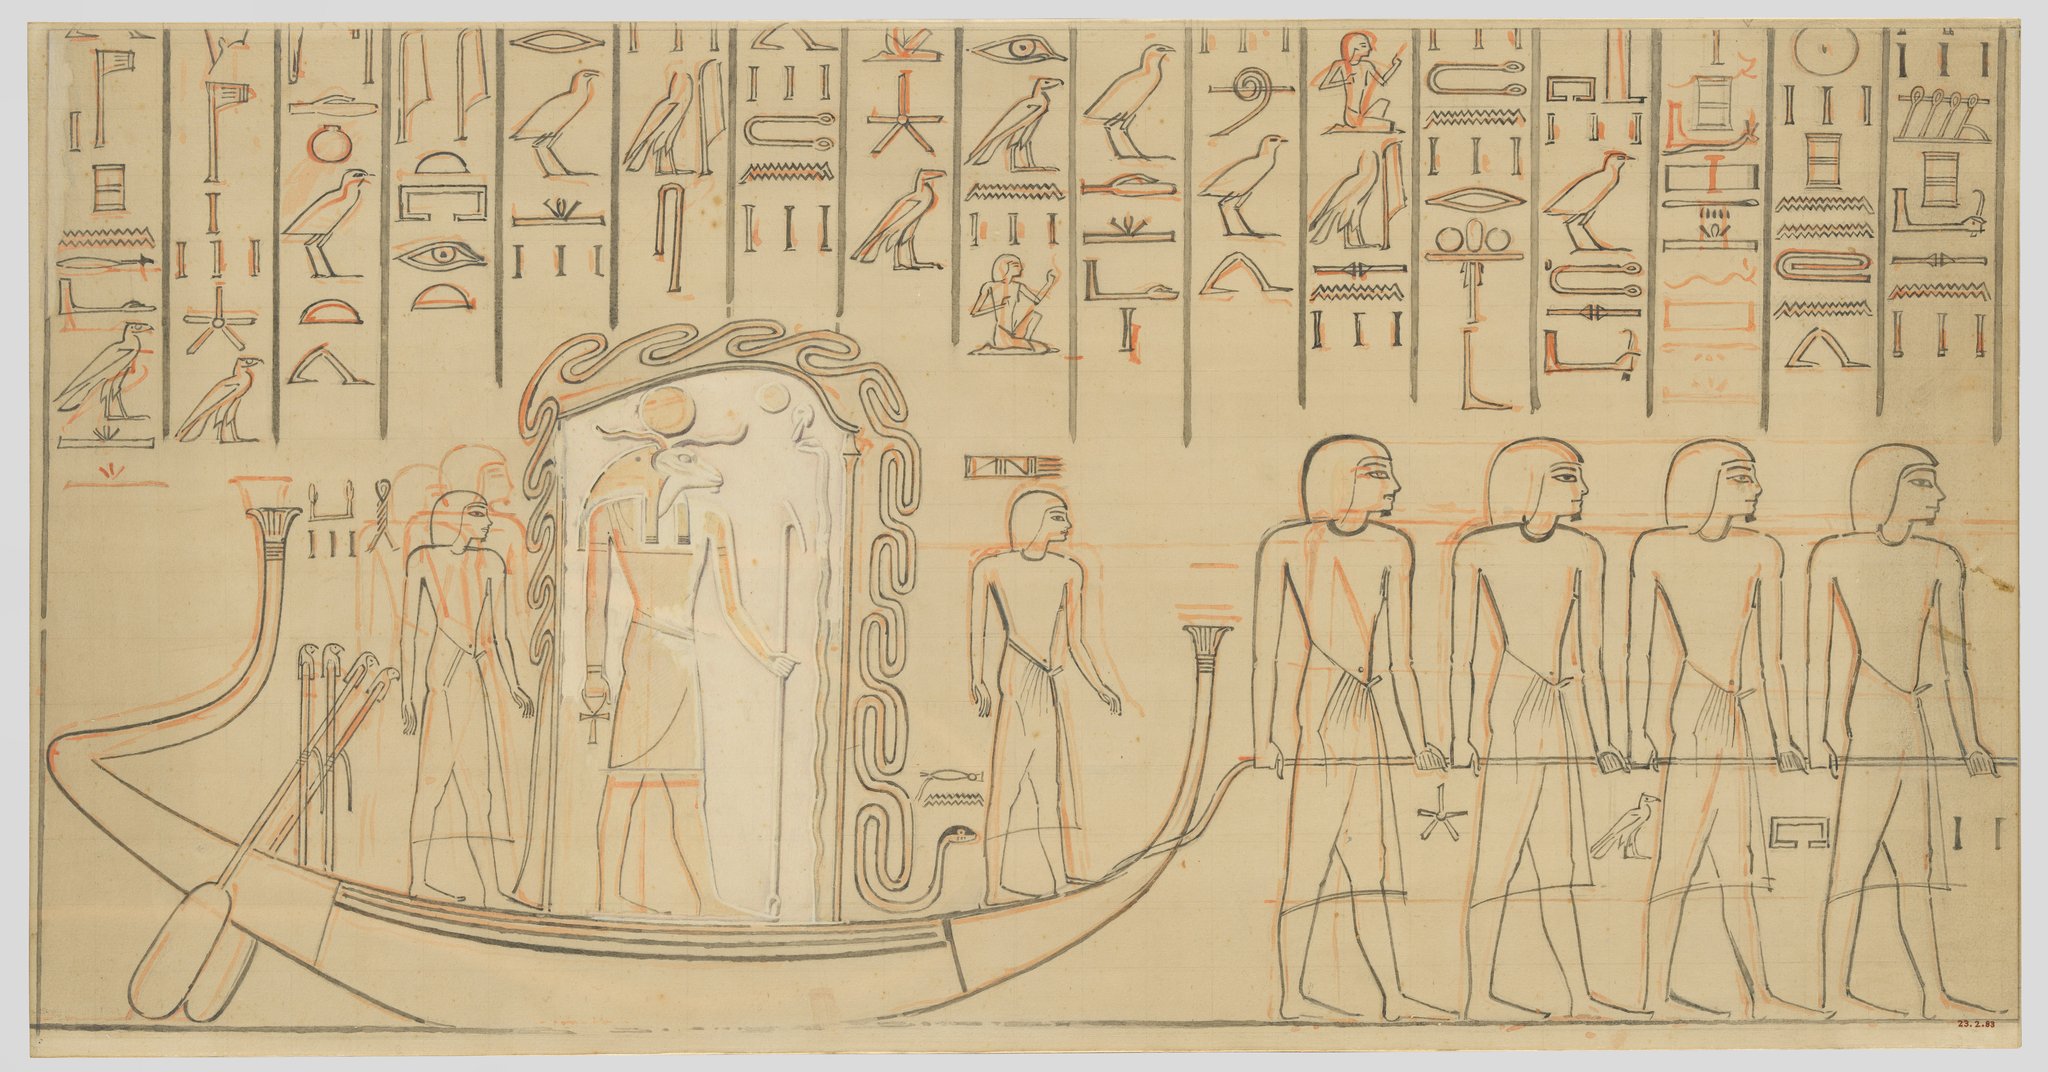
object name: facsimile, haremhab, kv 57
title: Wall painting of the Mehen snake protecting the barque of Re (facsimile)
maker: lancelot crane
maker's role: artist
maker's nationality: british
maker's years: 1880-1918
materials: paper, paint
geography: egypt